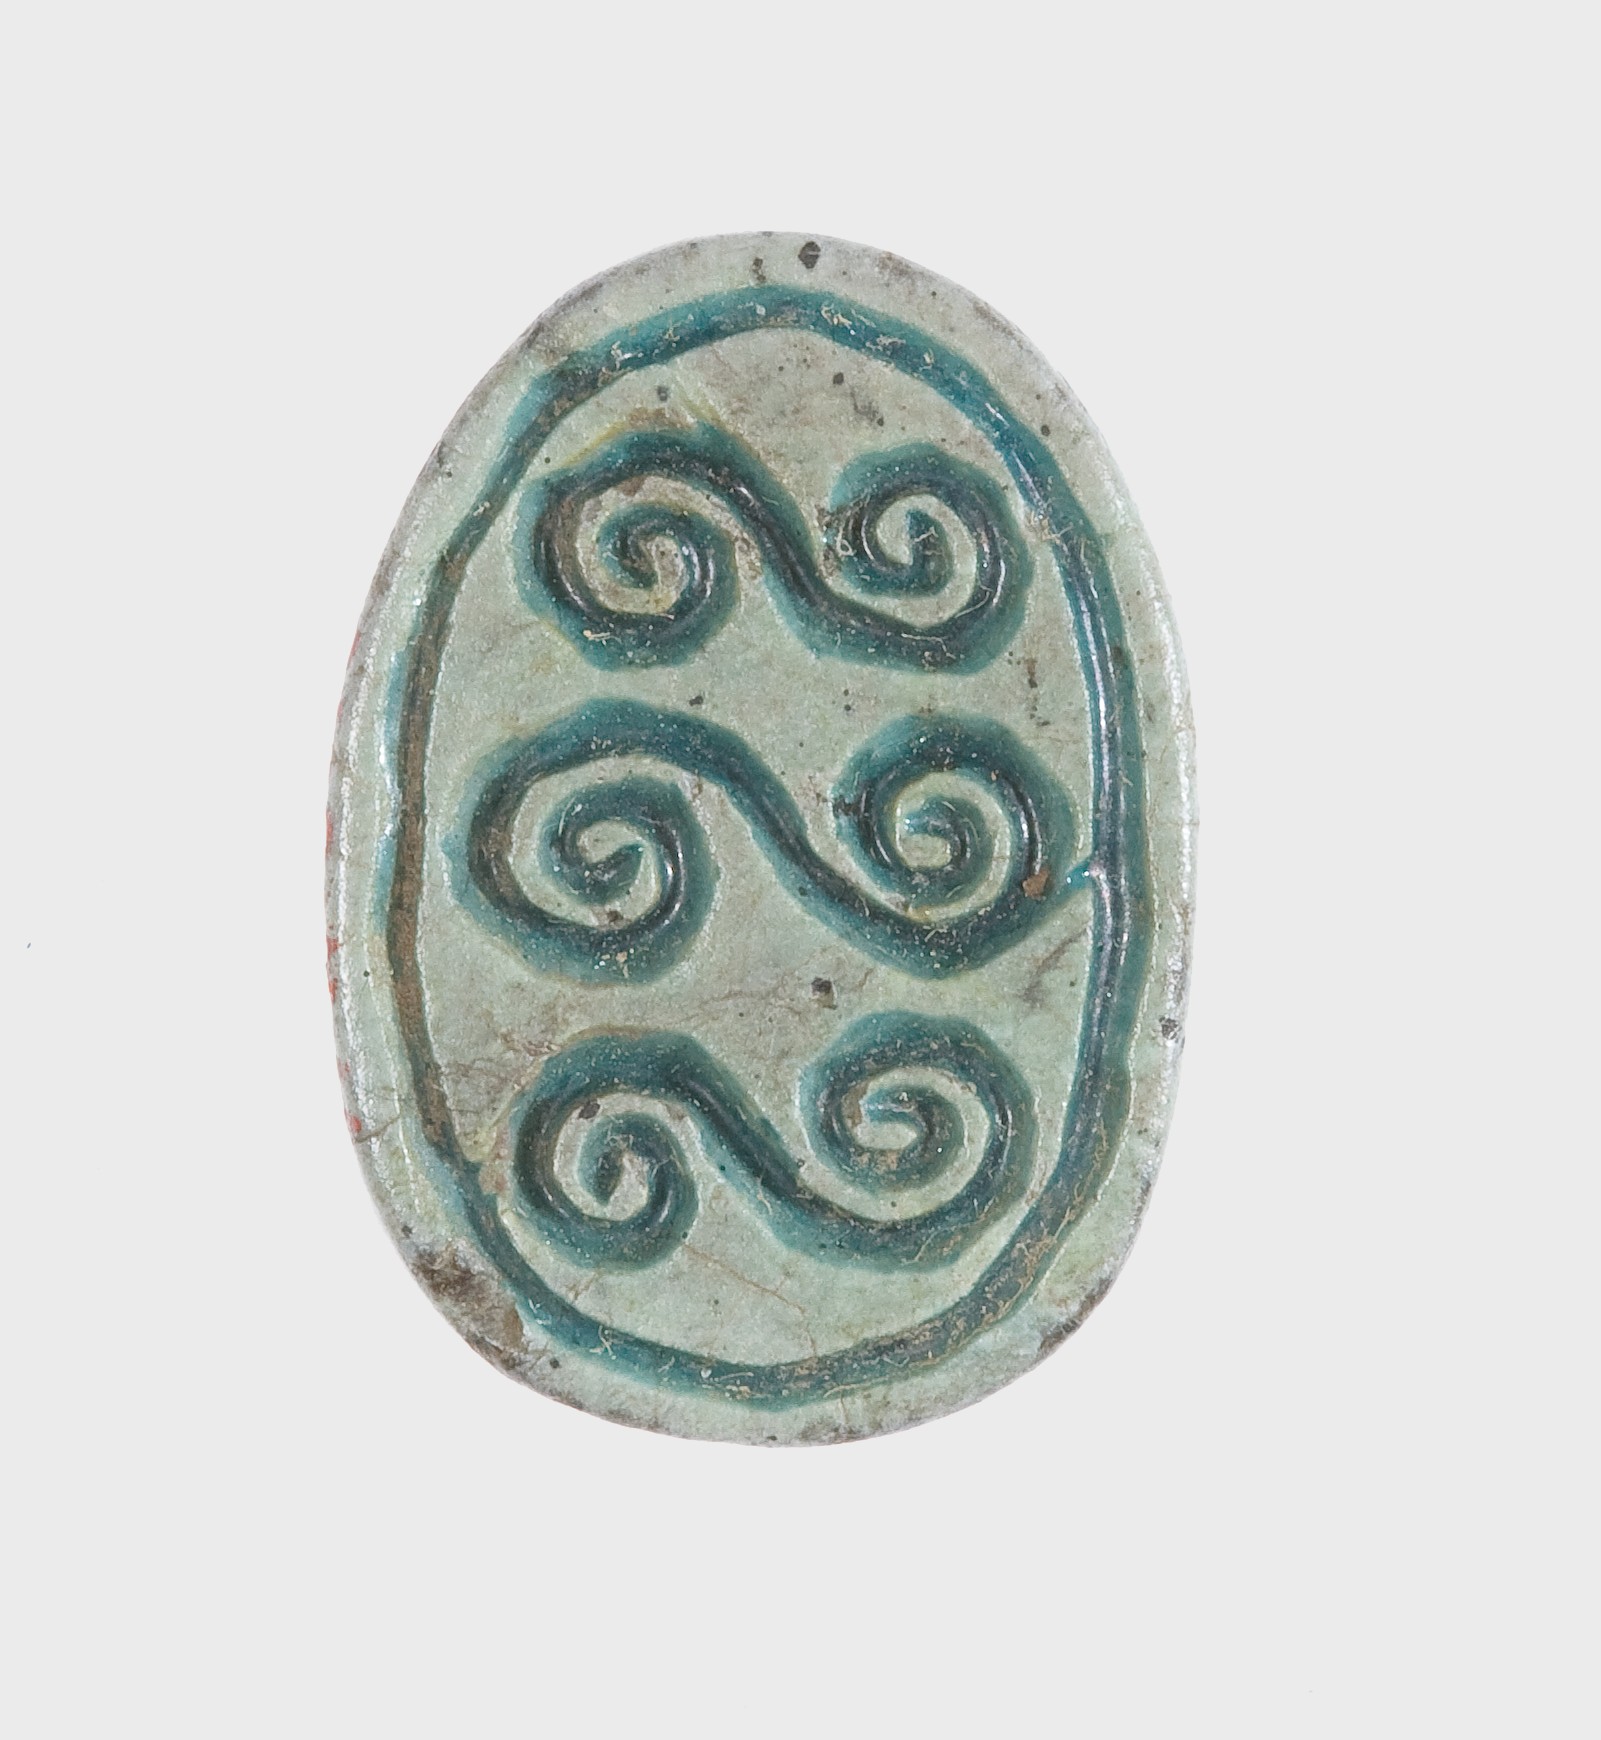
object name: scarab, spiral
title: Scarab Inscribed with S-Shaped Spirals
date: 1390-1352 BCE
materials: stone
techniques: glazing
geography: egypt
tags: scarabs